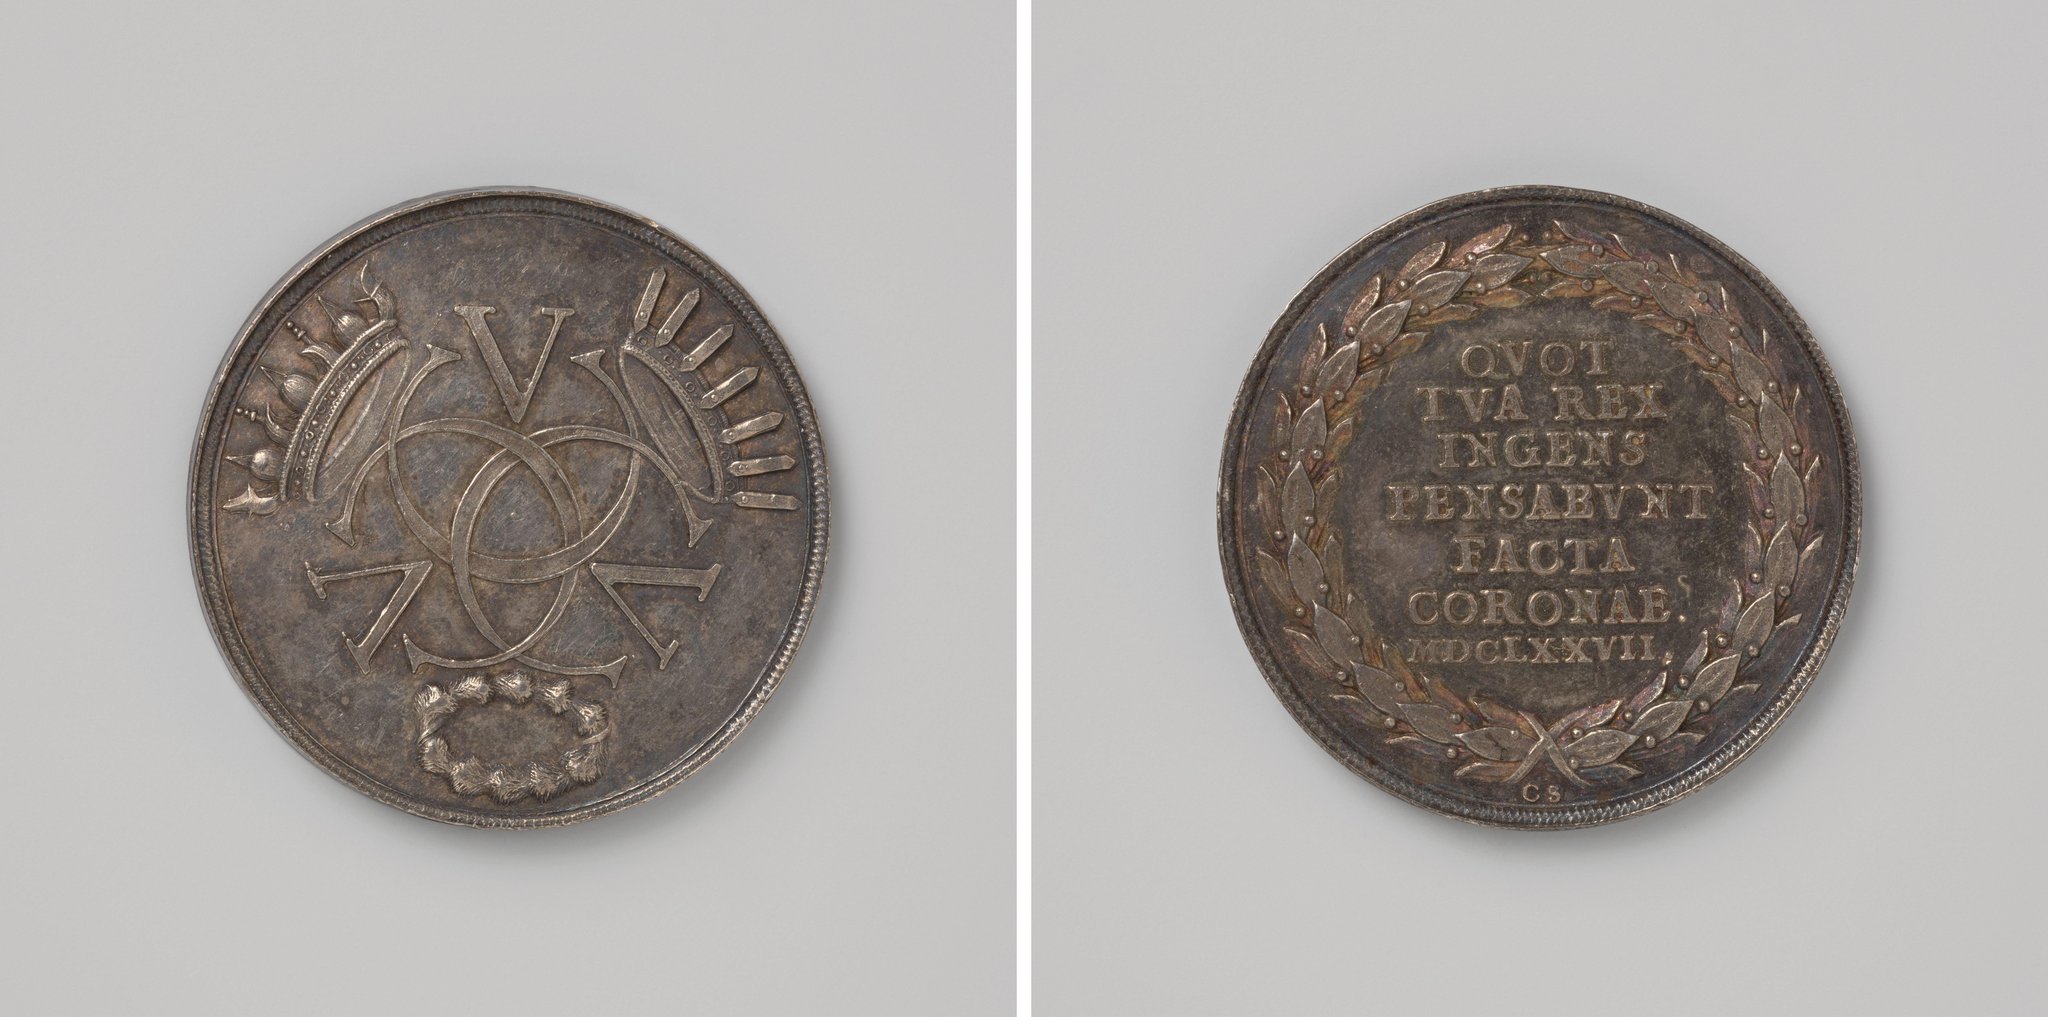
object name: history medal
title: Overwinning van de Denen op de Zweden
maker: christoffer schneider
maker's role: medailleur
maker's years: -1701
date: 1677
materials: silver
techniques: striking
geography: copenhagen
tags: koning, christiaan v (koning van denemarken en noorwegen), faeröer, zweden, noordse oorlogen, schonense oorlog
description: Zilveren penning. Voorzijde: drie maal dooreen gevlochten het monogram van Christian V van Denemarken tussen twee kronen en lauwerkrans. Keerzijde: opschrift in lauwerkrans